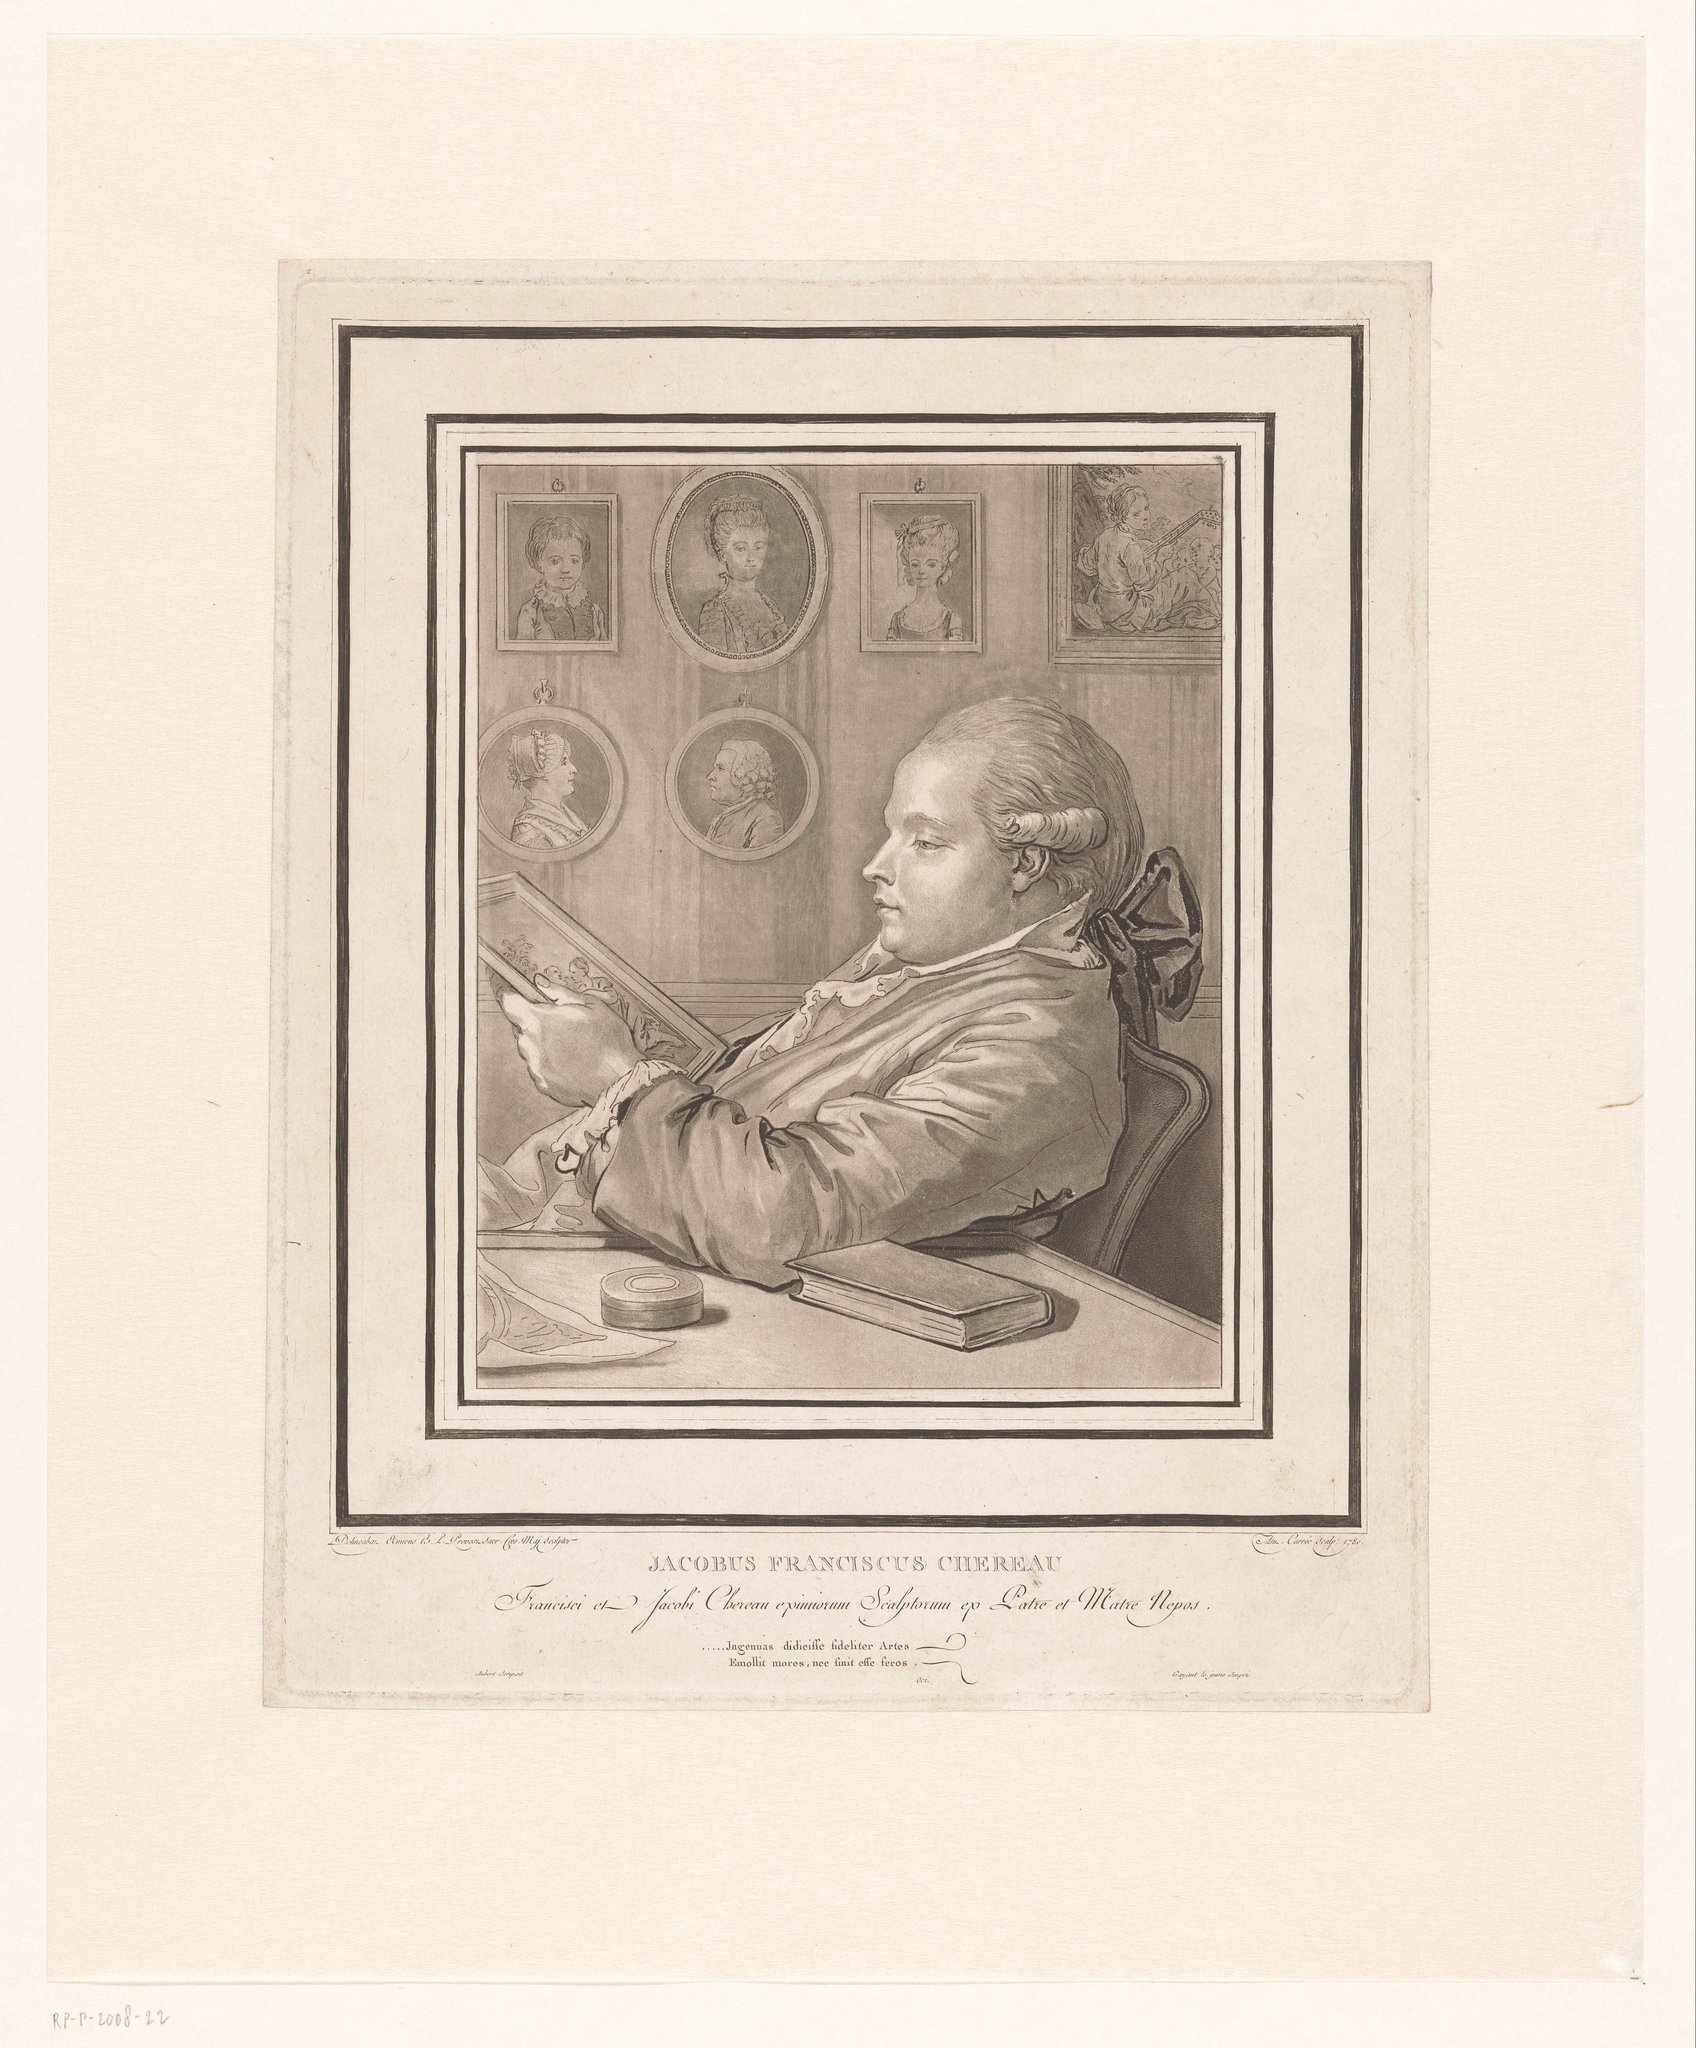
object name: print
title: Portret van Jacques-François Chéreau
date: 1780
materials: paper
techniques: aquatint, etching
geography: france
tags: jacques-françois chéreau, art, print, e.g.: engraving, etching, lithograph, historical persons, art dealer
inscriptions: collector's mark: Lugt 2760, collector's mark: Lugt 2228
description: De prenthandelaar Jacques-François Chéreau, een prent bekijkend